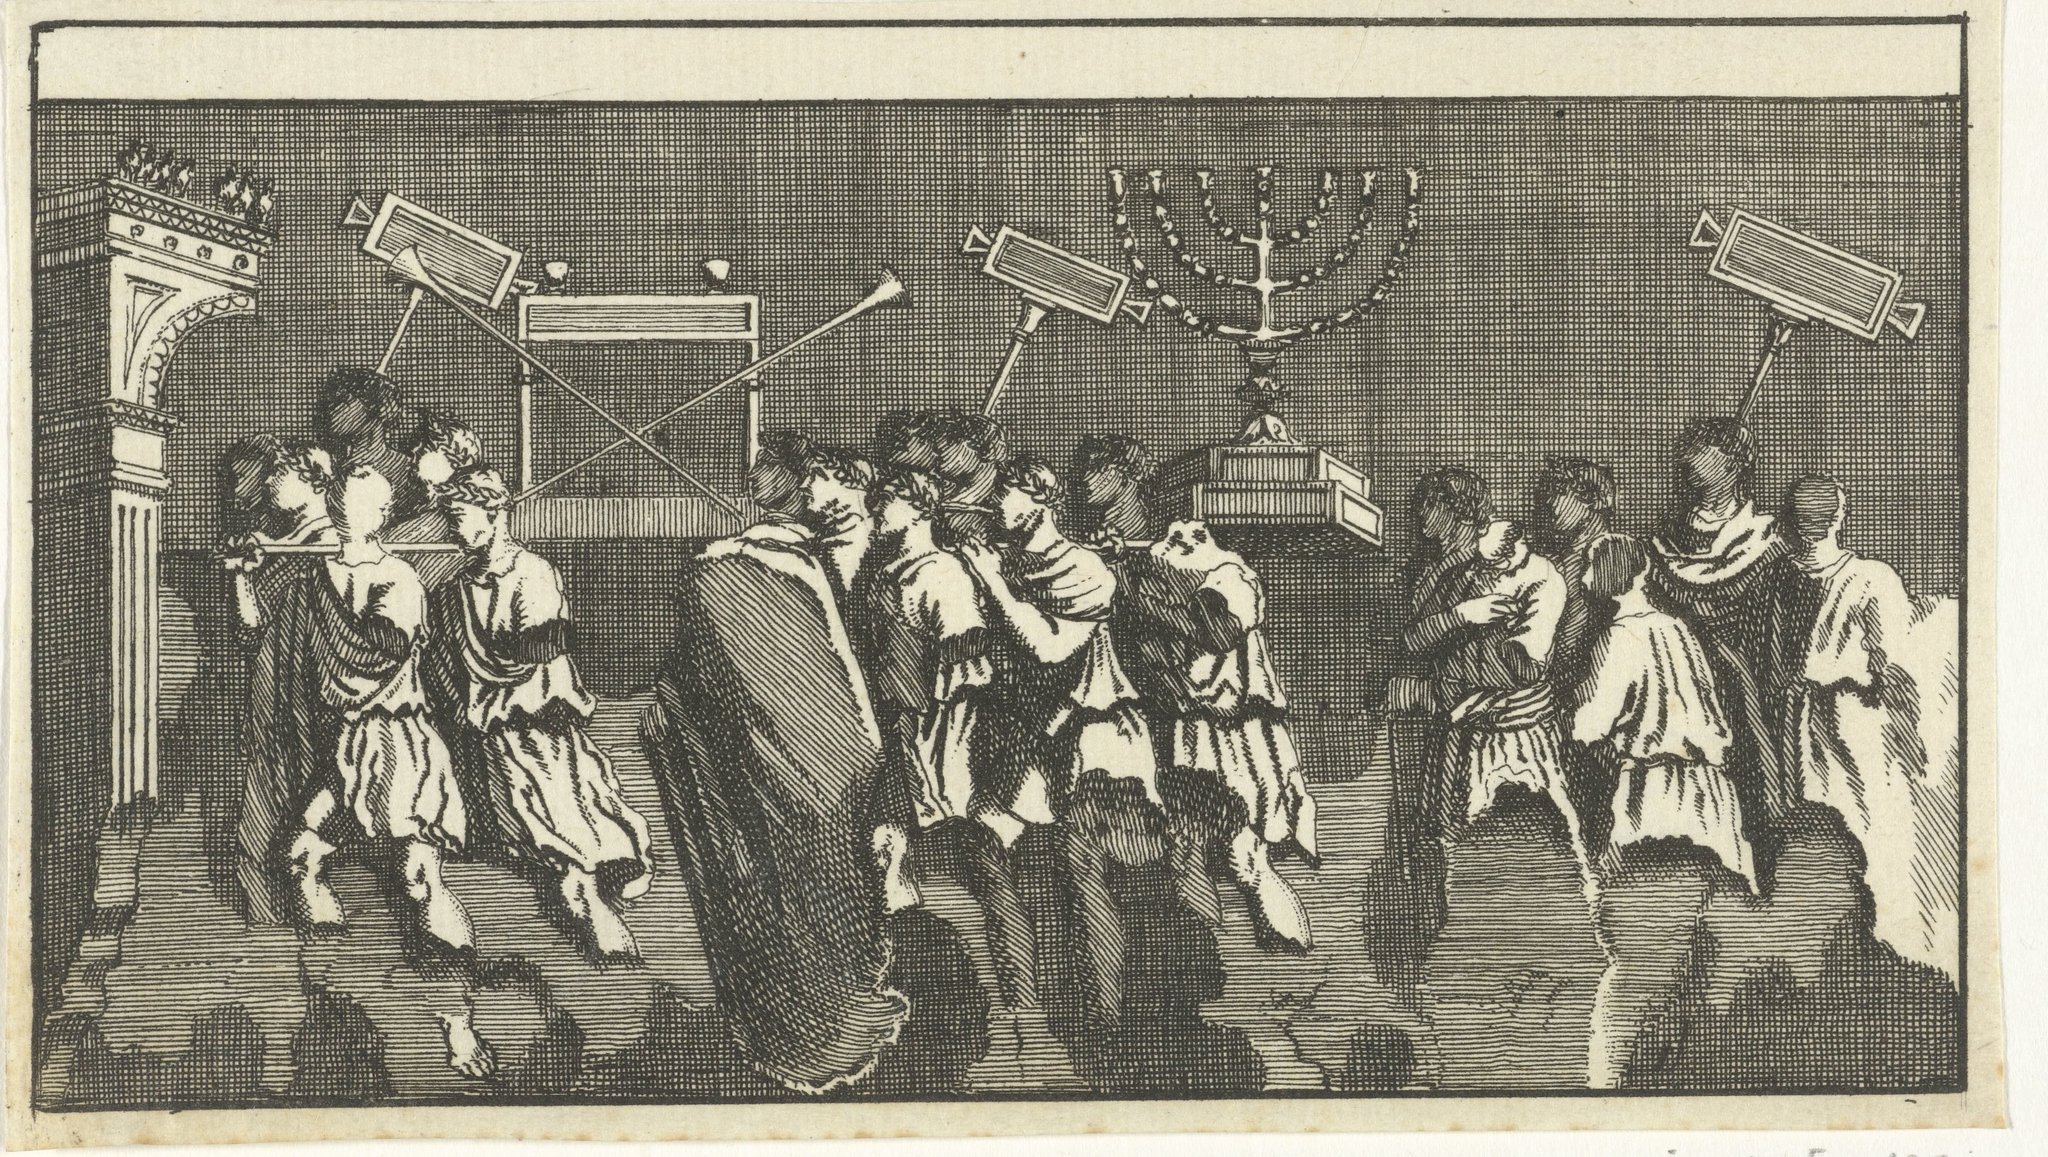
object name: print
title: Reliëf van de boog van Titus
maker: Anonymous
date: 1682-1762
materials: paper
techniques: etching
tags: triumphal arch, piece of sculpture, reproduction of a piece of sculpture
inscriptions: collector's mark: Lugt 2228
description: Origineel opgenomen in: Cunaeus, Petrus. De republyk der Hebreen, of gemeenebest der joden, 3 delen. Amsterdam: Wilhelmus Goeree, 1682, dl. 1, p. 260.